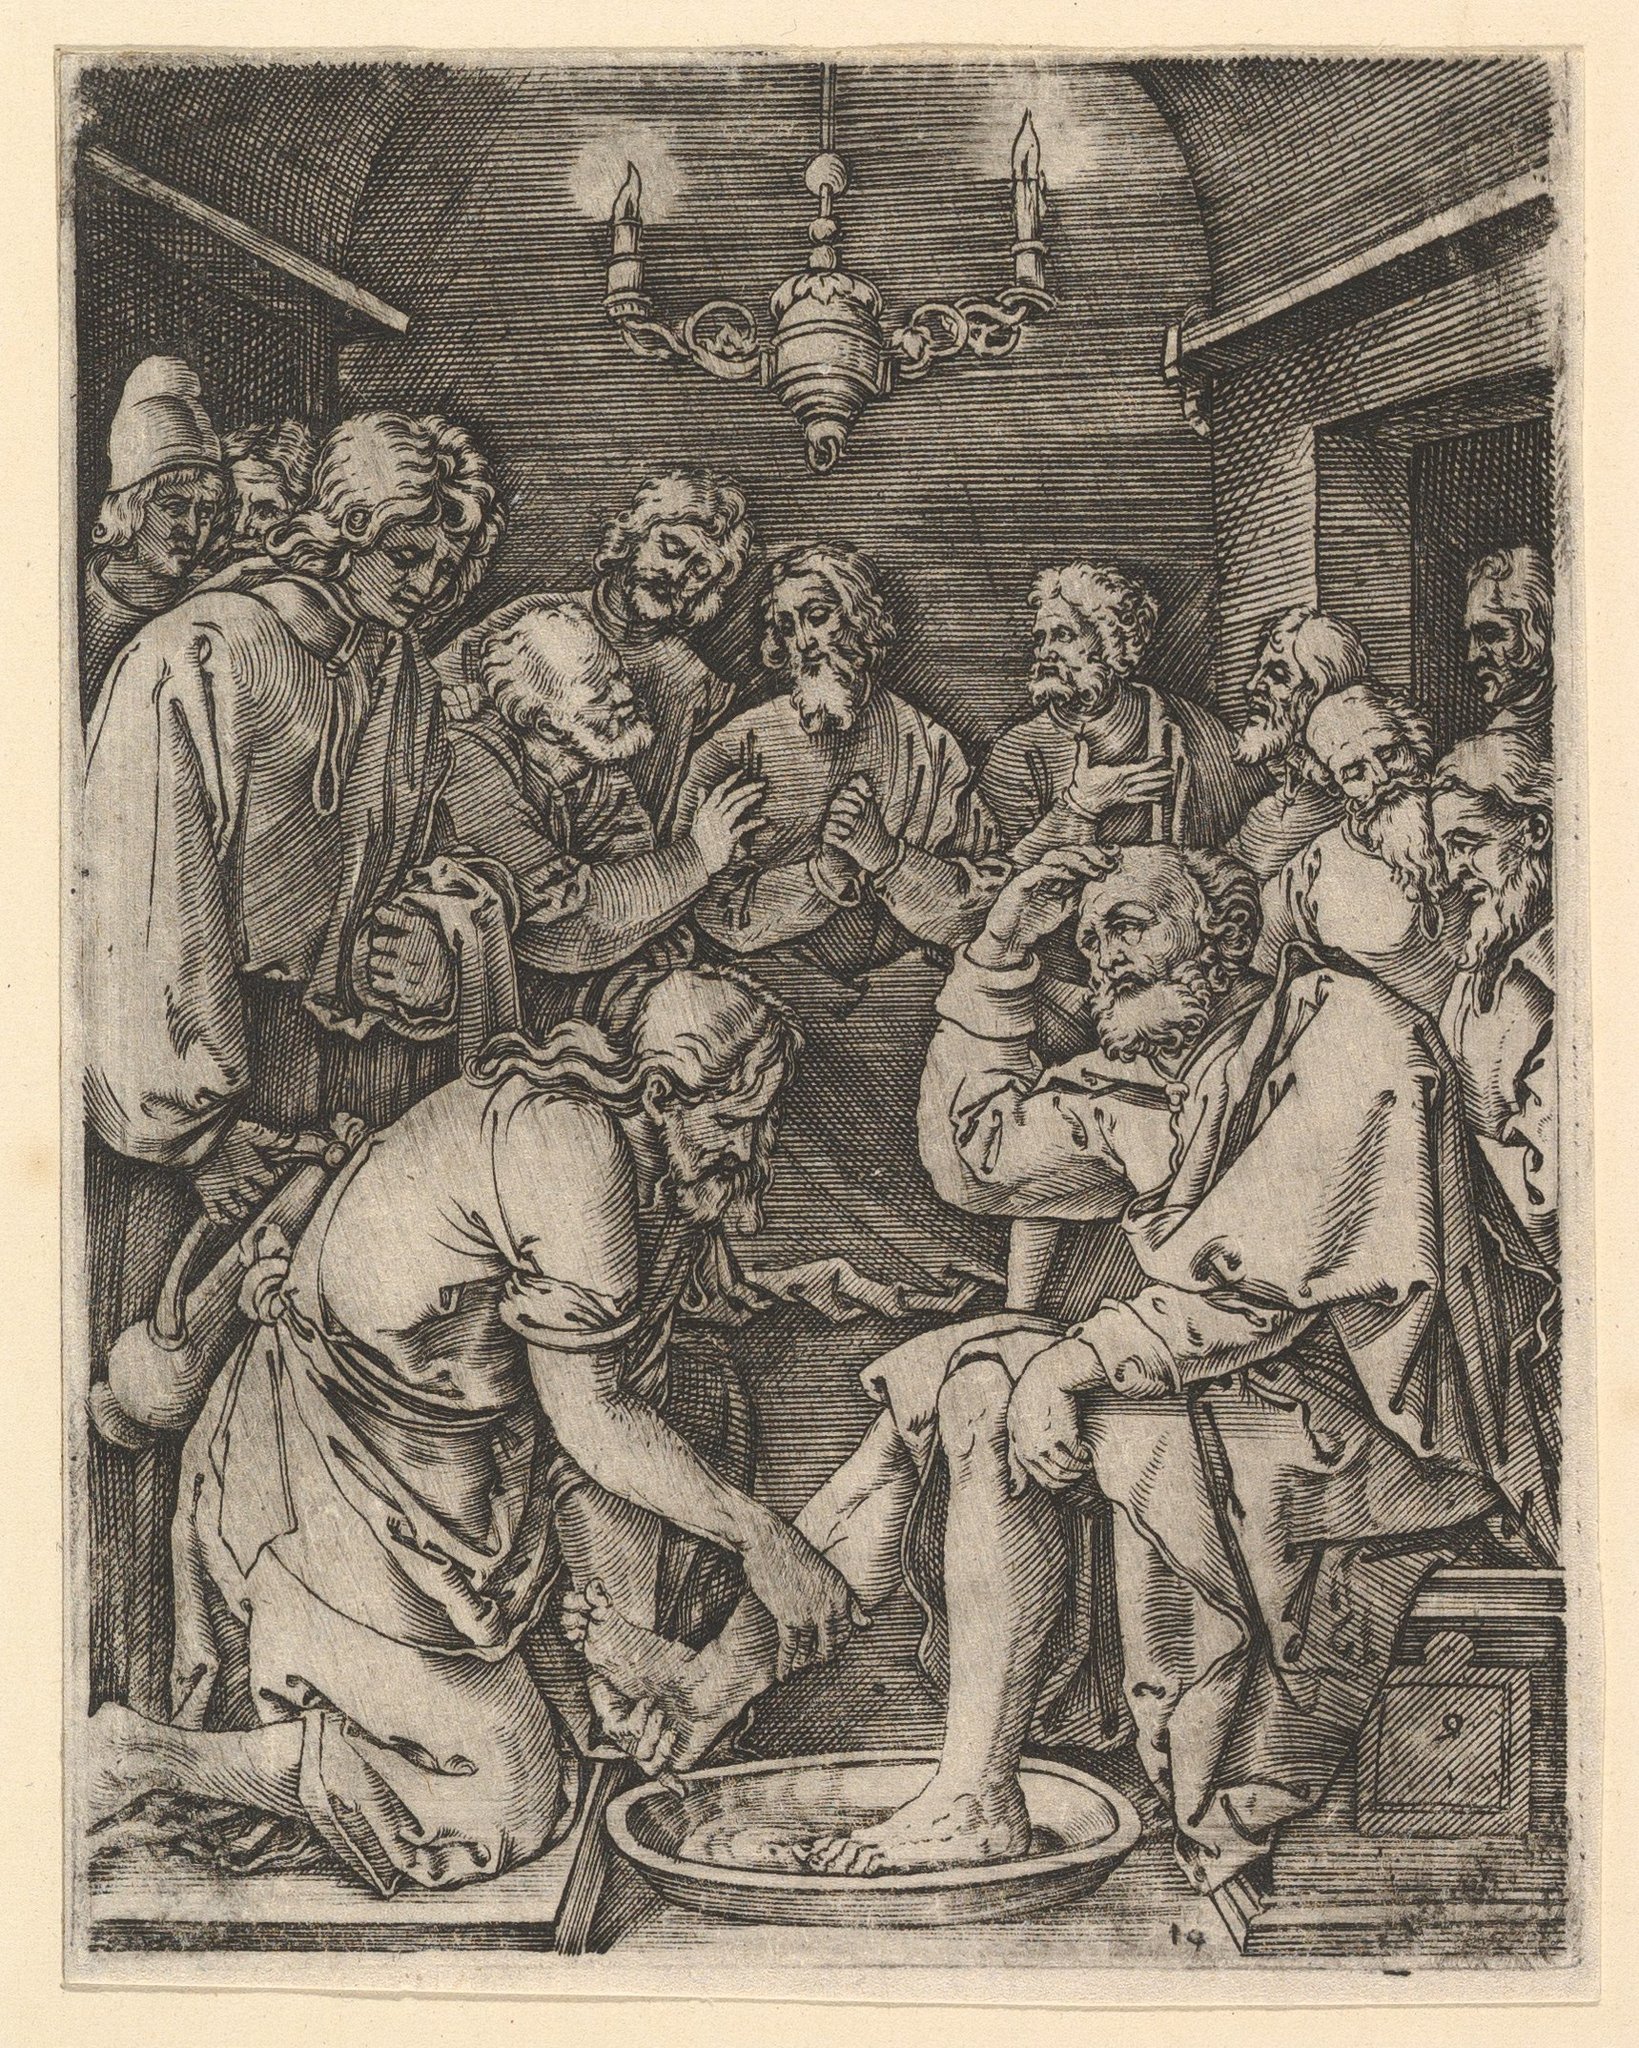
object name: print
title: Christ kneeling and washing St Peter's feet, from "The Passion of Christ"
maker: marcantonio raimondi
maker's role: artist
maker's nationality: italian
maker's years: 1475-1534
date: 1500-1534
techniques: engraving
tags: apostles,christ,saint peter,washing